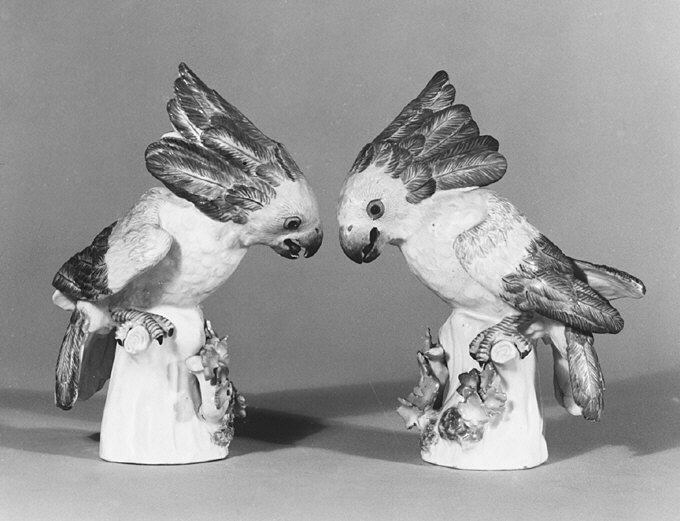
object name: figure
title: Cockatoo (one of a pair)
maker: meissen manufactory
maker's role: manufactory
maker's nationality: german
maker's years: 1710-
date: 1737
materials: hard paste porcelain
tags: birds